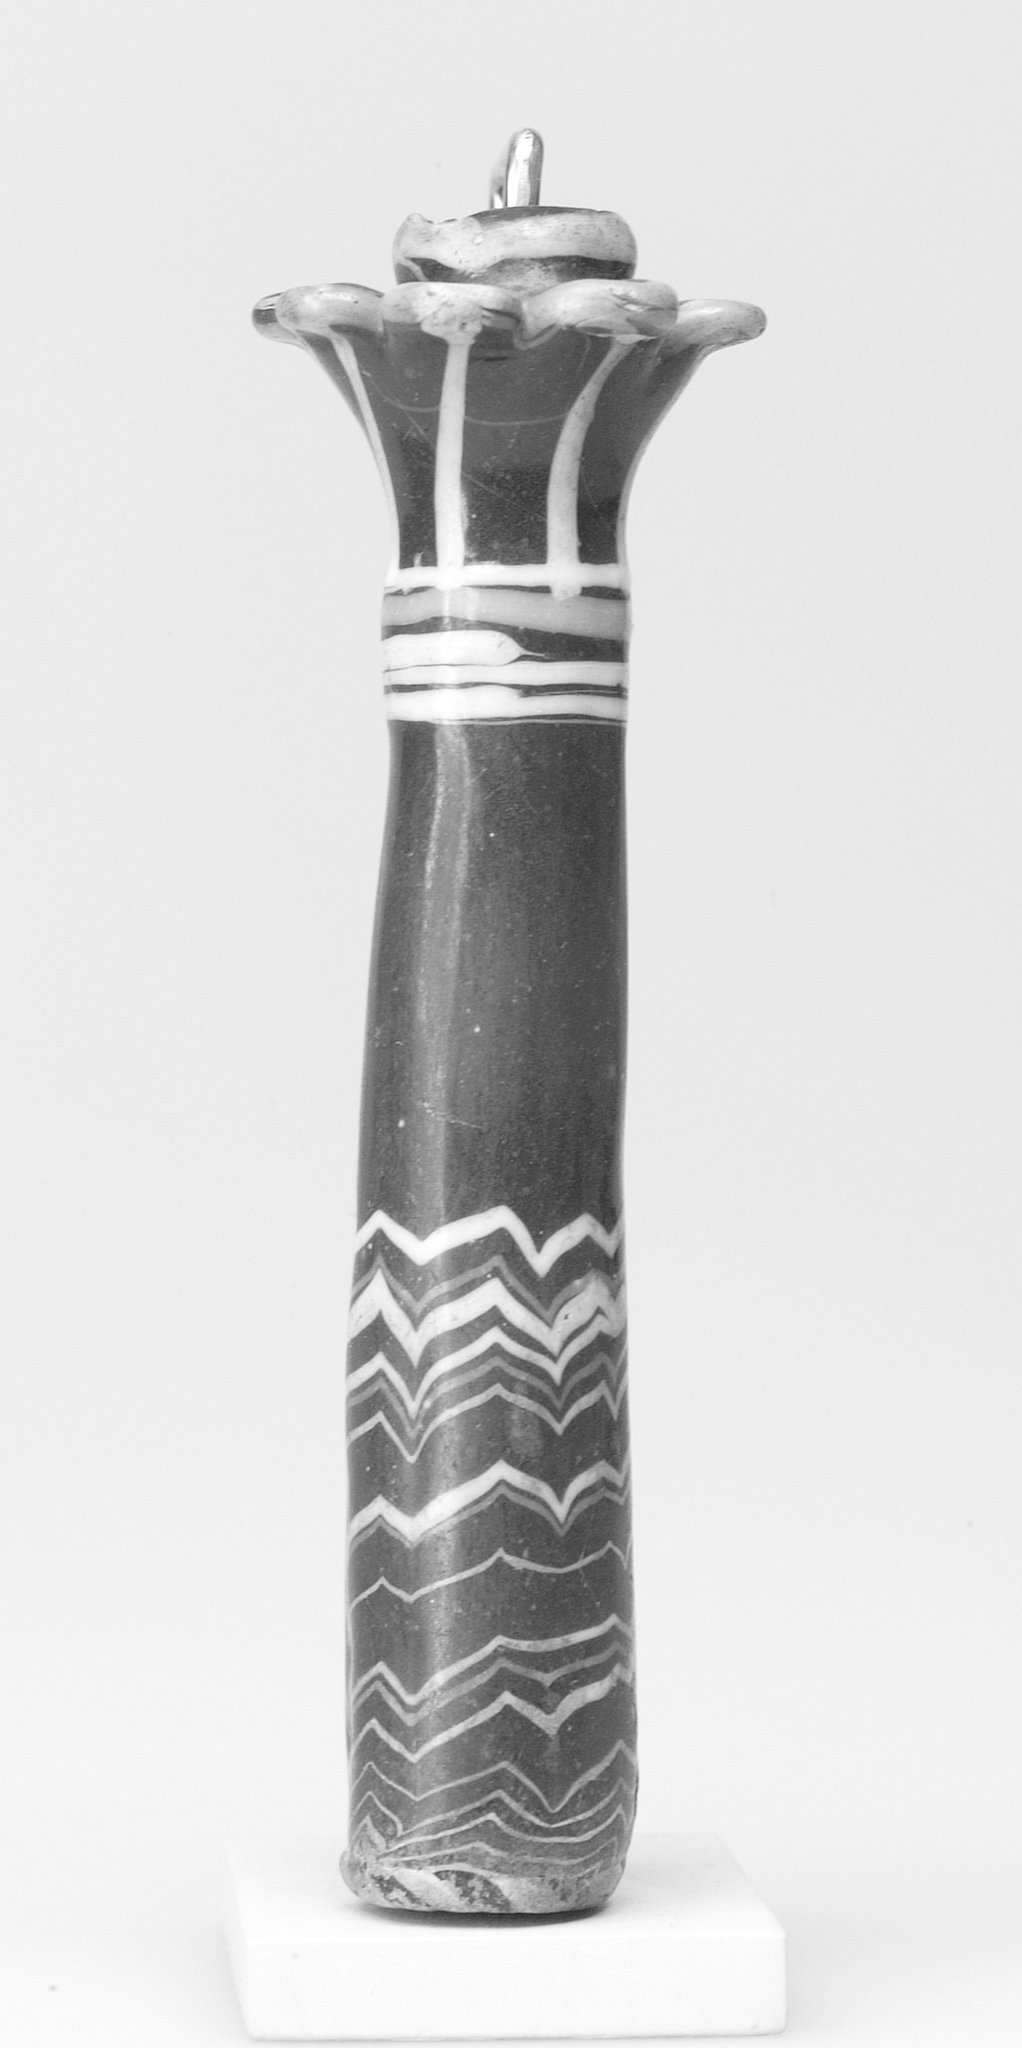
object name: kohl tube, papyrus column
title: Tube for Eye Paint (Kohl) in the Shape of a Papyrus Column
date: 1550-1295 BCE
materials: glass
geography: egypt